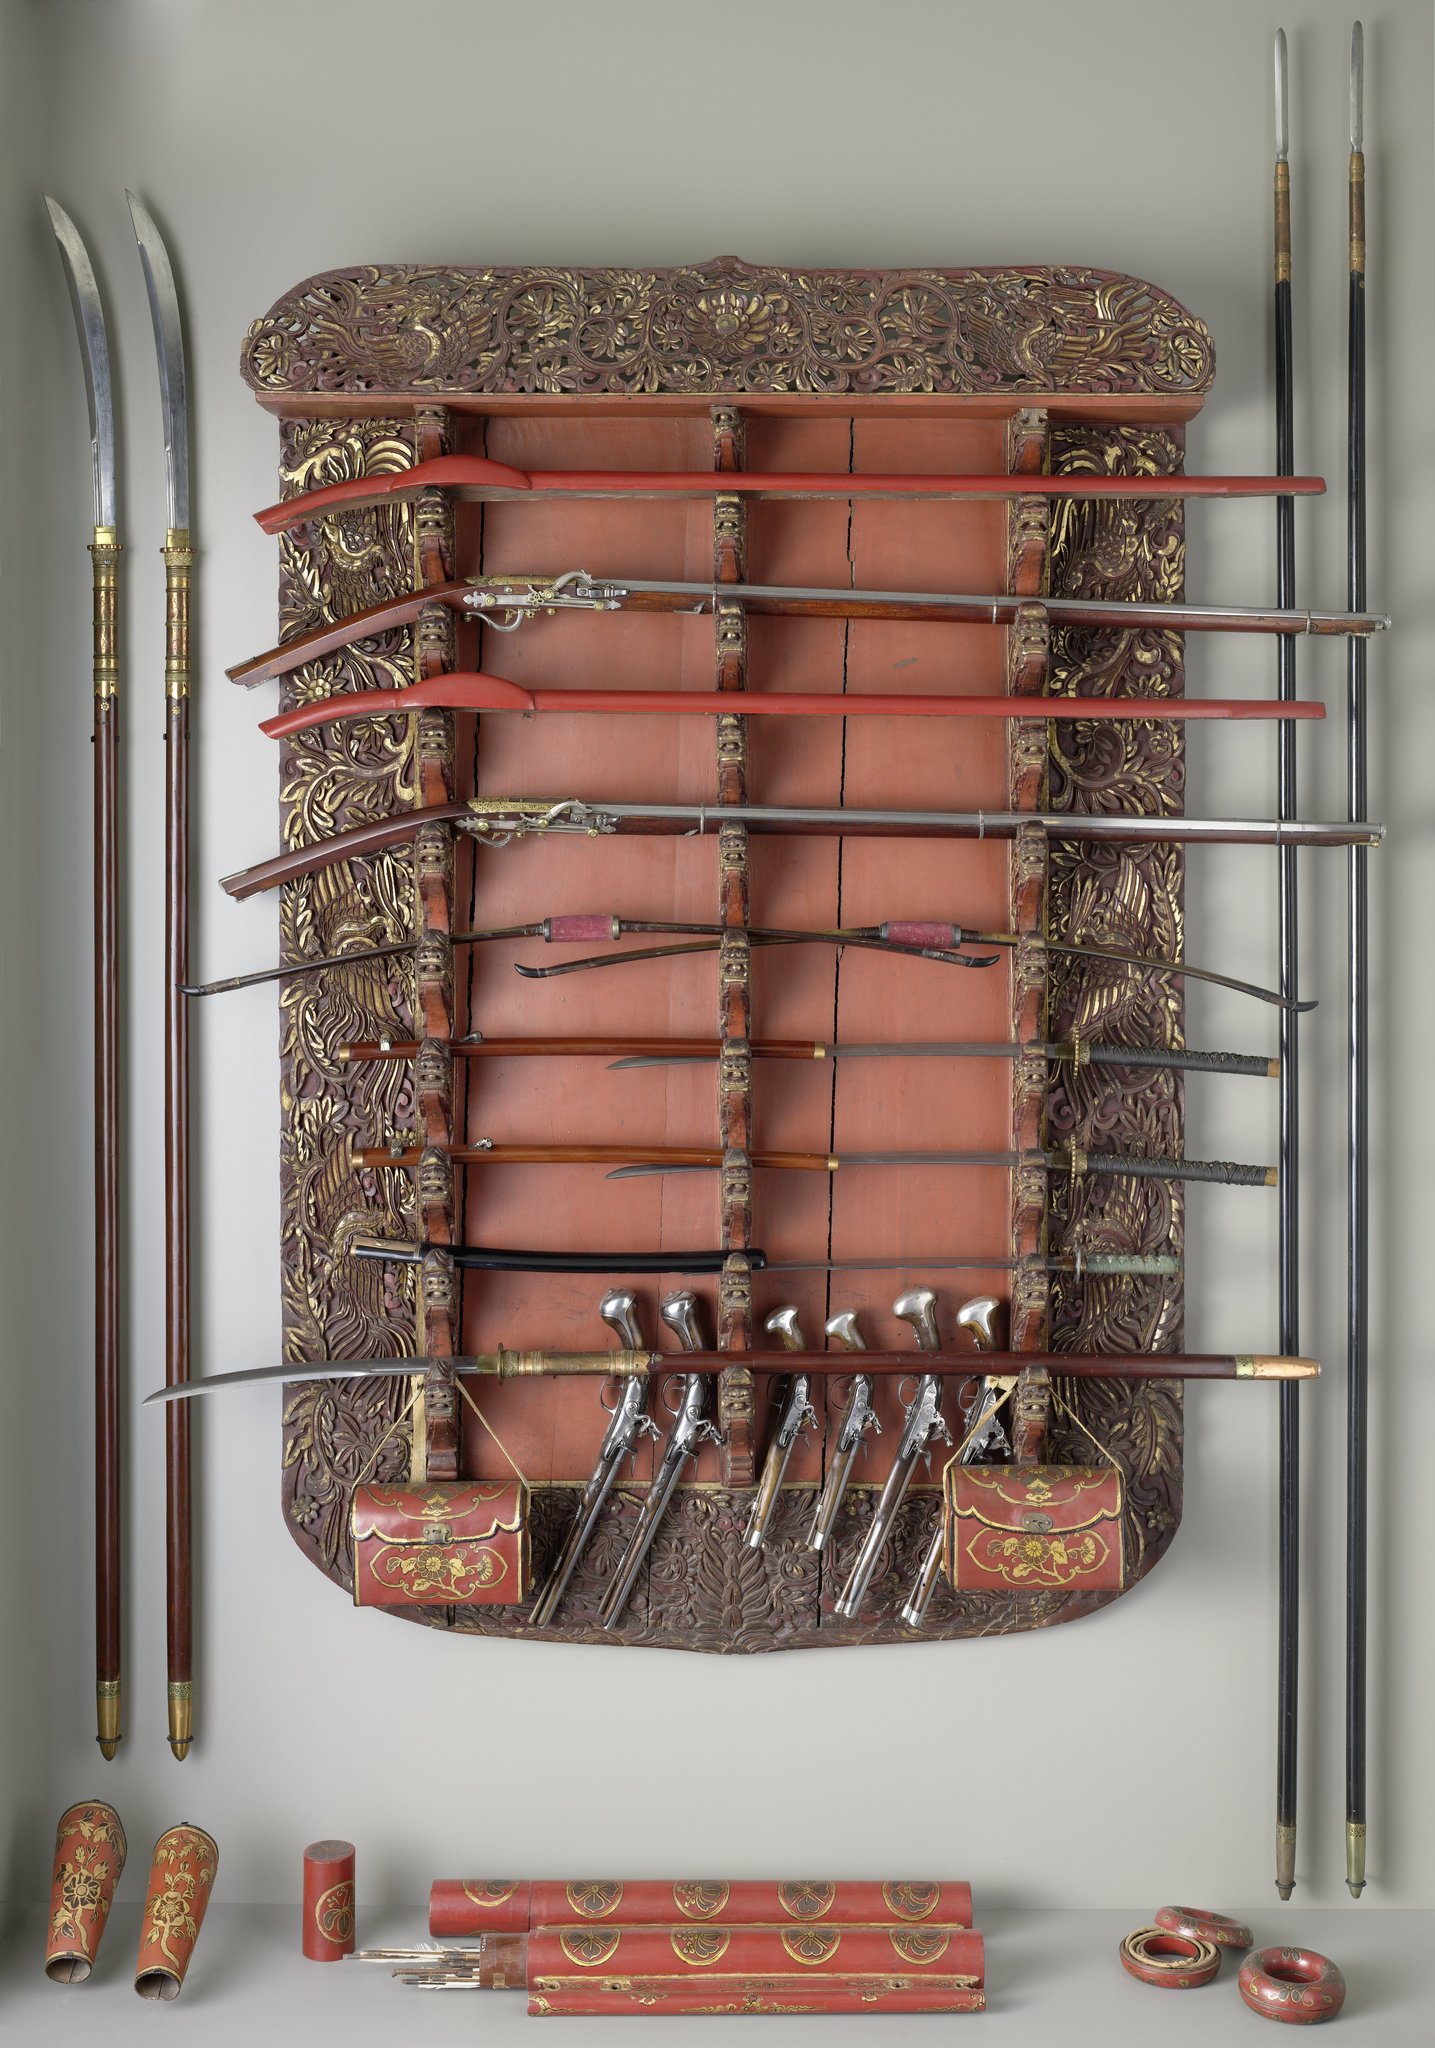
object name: arm rack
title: Weapon rack Cornelis Tromp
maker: Anonymous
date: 1650-1679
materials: paint, red lacquer, wood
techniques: gilding, lacquer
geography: north vietnam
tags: rotterdam, amsterdam, cornelis tromp, indonesia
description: With this rack of oriental weapons, Admiral Cornelis Tromp demonstrated his hero status at home. He was given the rack in 1680, together with a large number of exotic weapons, by an old friend from Batavia (now Jakarta). Some of the weapons, such as the lances, come from the Japanese island of Tanegashima. Most have a red-lacquered wooden case. Tromp also hung three pairs of fine Dutch pistols on the rack.